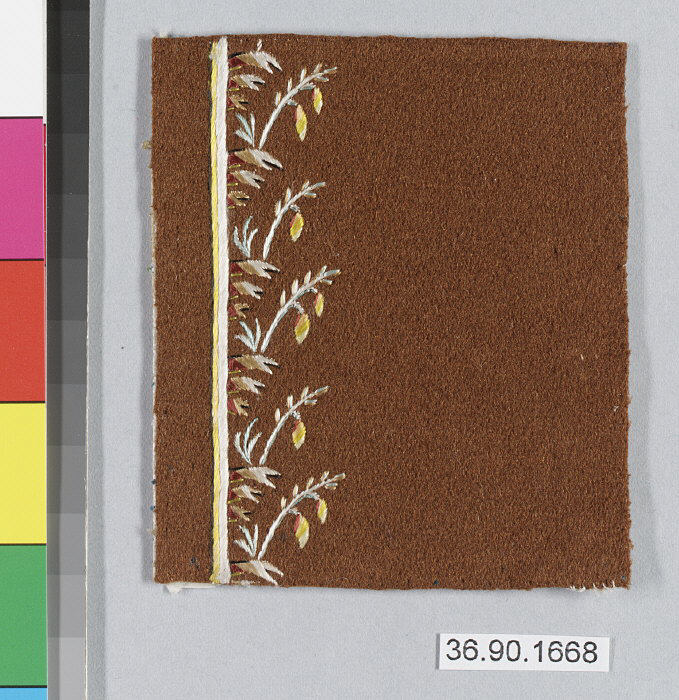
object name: sample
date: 1801-1833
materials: felt, silk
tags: plants